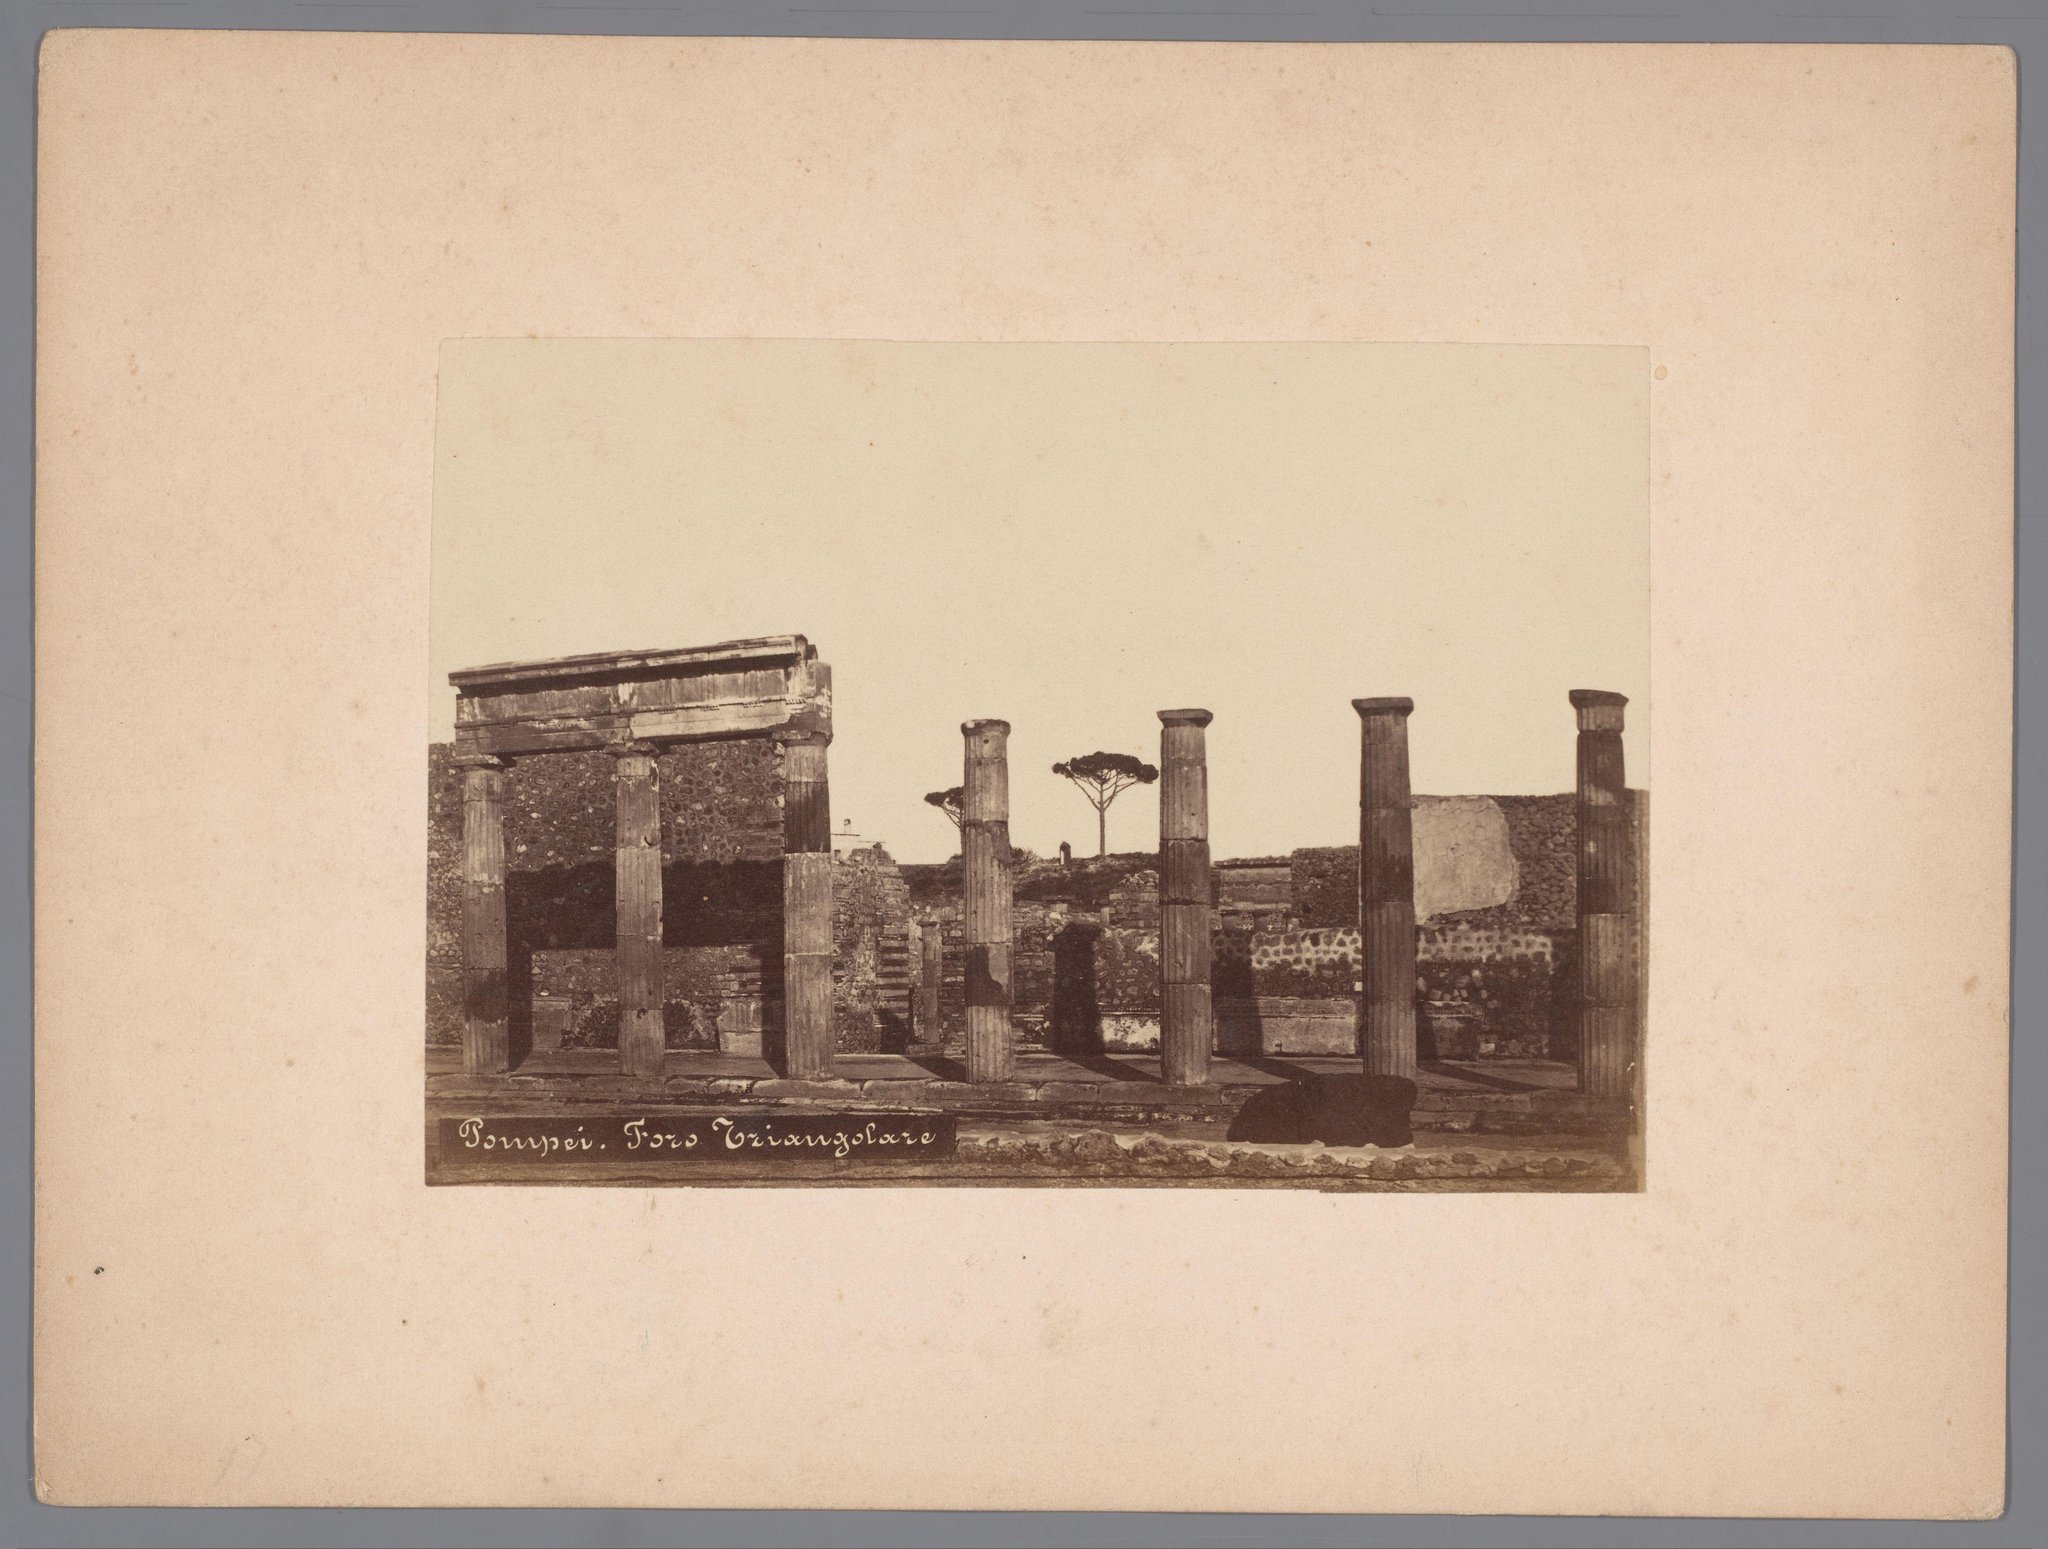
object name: photograph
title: Gezicht op het Foro Triangolare te Pompeï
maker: giorgio sommer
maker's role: fotograaf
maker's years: 1834-1914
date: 1857-1914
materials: cardboard, paper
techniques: albumen print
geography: pompeii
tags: square, place, circus, etc., devastated, ruined place or city (~ warfare)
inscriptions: inscription: ‘10’, collector's mark: ‘VOSMAER’, inscription: ‘P’